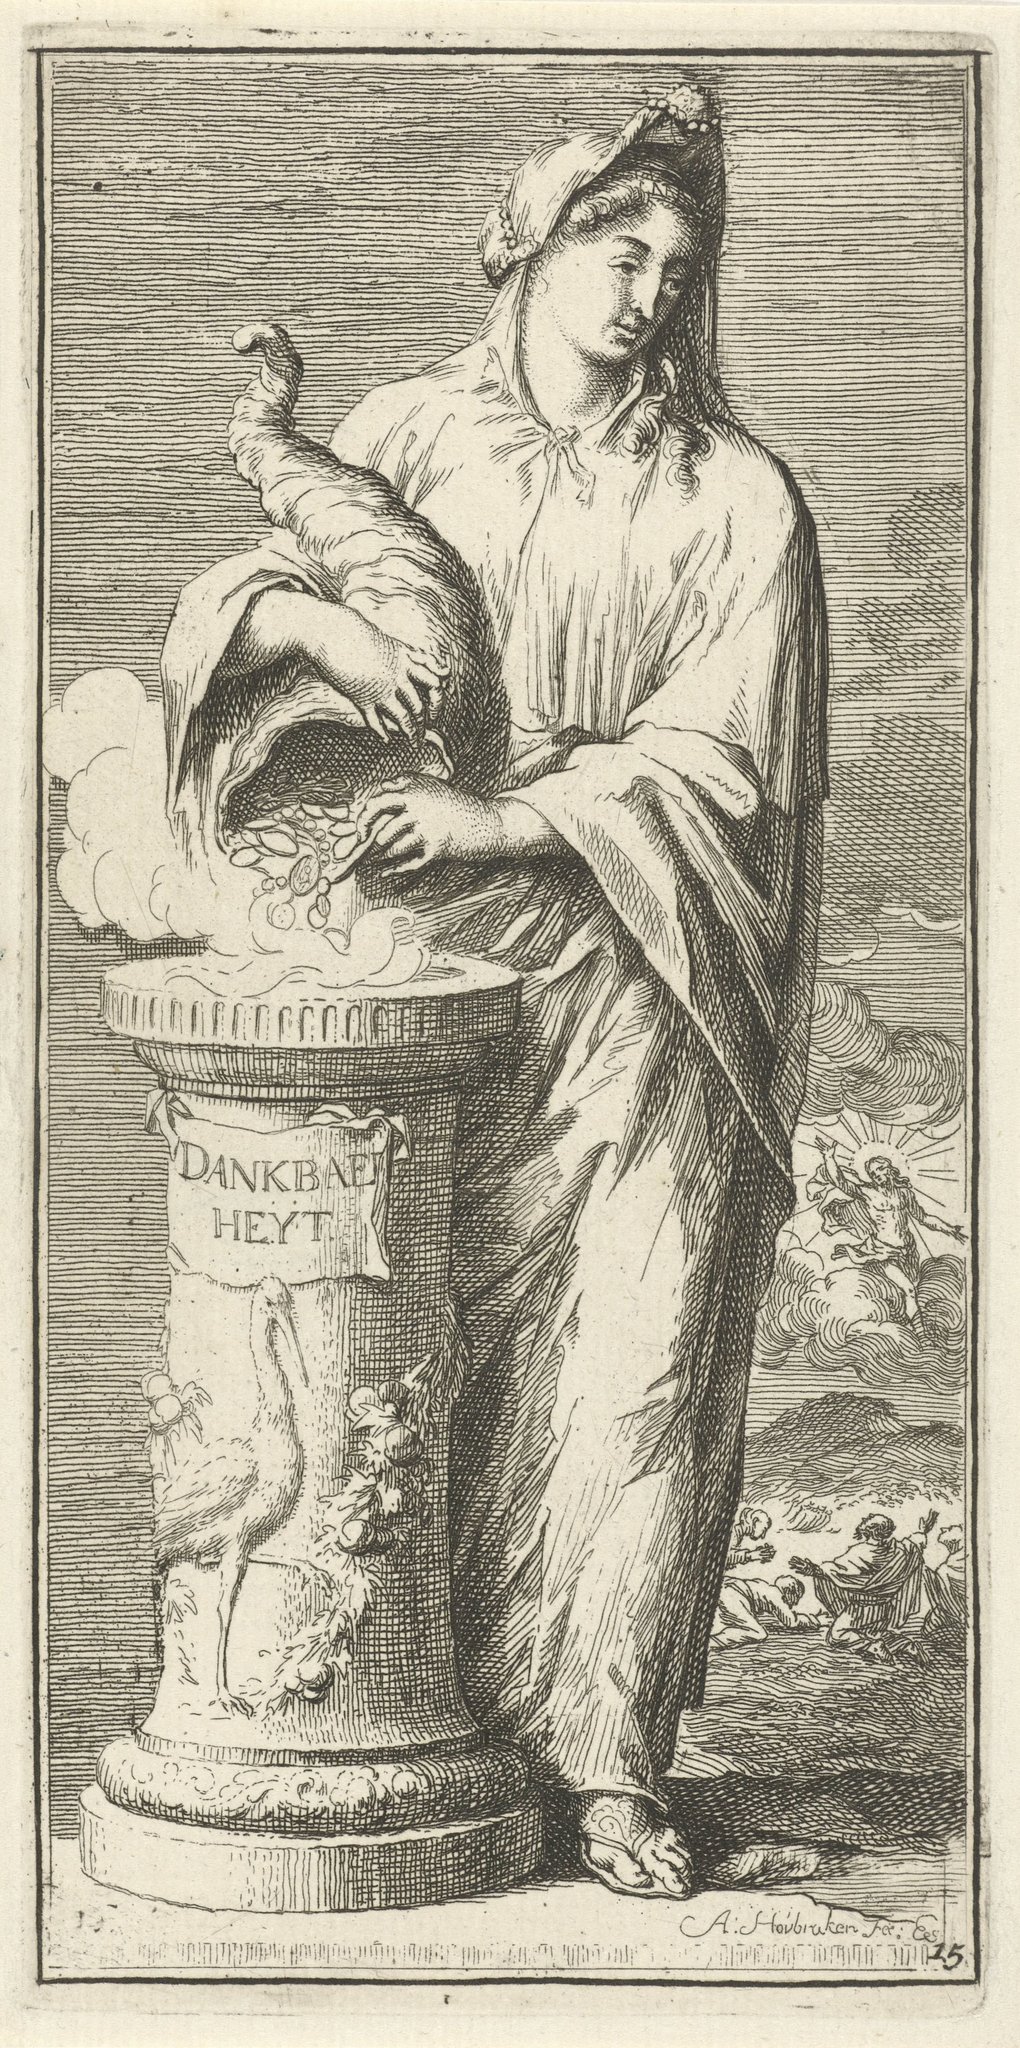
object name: print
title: Dankbaerheyt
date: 1710-1719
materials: paper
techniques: engraving, etching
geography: amsterdam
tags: coin, sacrifice, gratitude; 'gratitudine', 'memoria grata de beneficii ricevuti' (ripa) (+ abstract concept represented by female figure)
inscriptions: collector's mark: Lugt 2228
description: Een vrouwfiguur als personificatie van de dankbaarheid. Zij heeft een hoorn des overvloeds vast en stort daaruit munten uit boven een offerzuil. Op de achtergrond verschijnt Christus aan geknielde figuren. Prent uit een serie van 41 zinnebeelden.